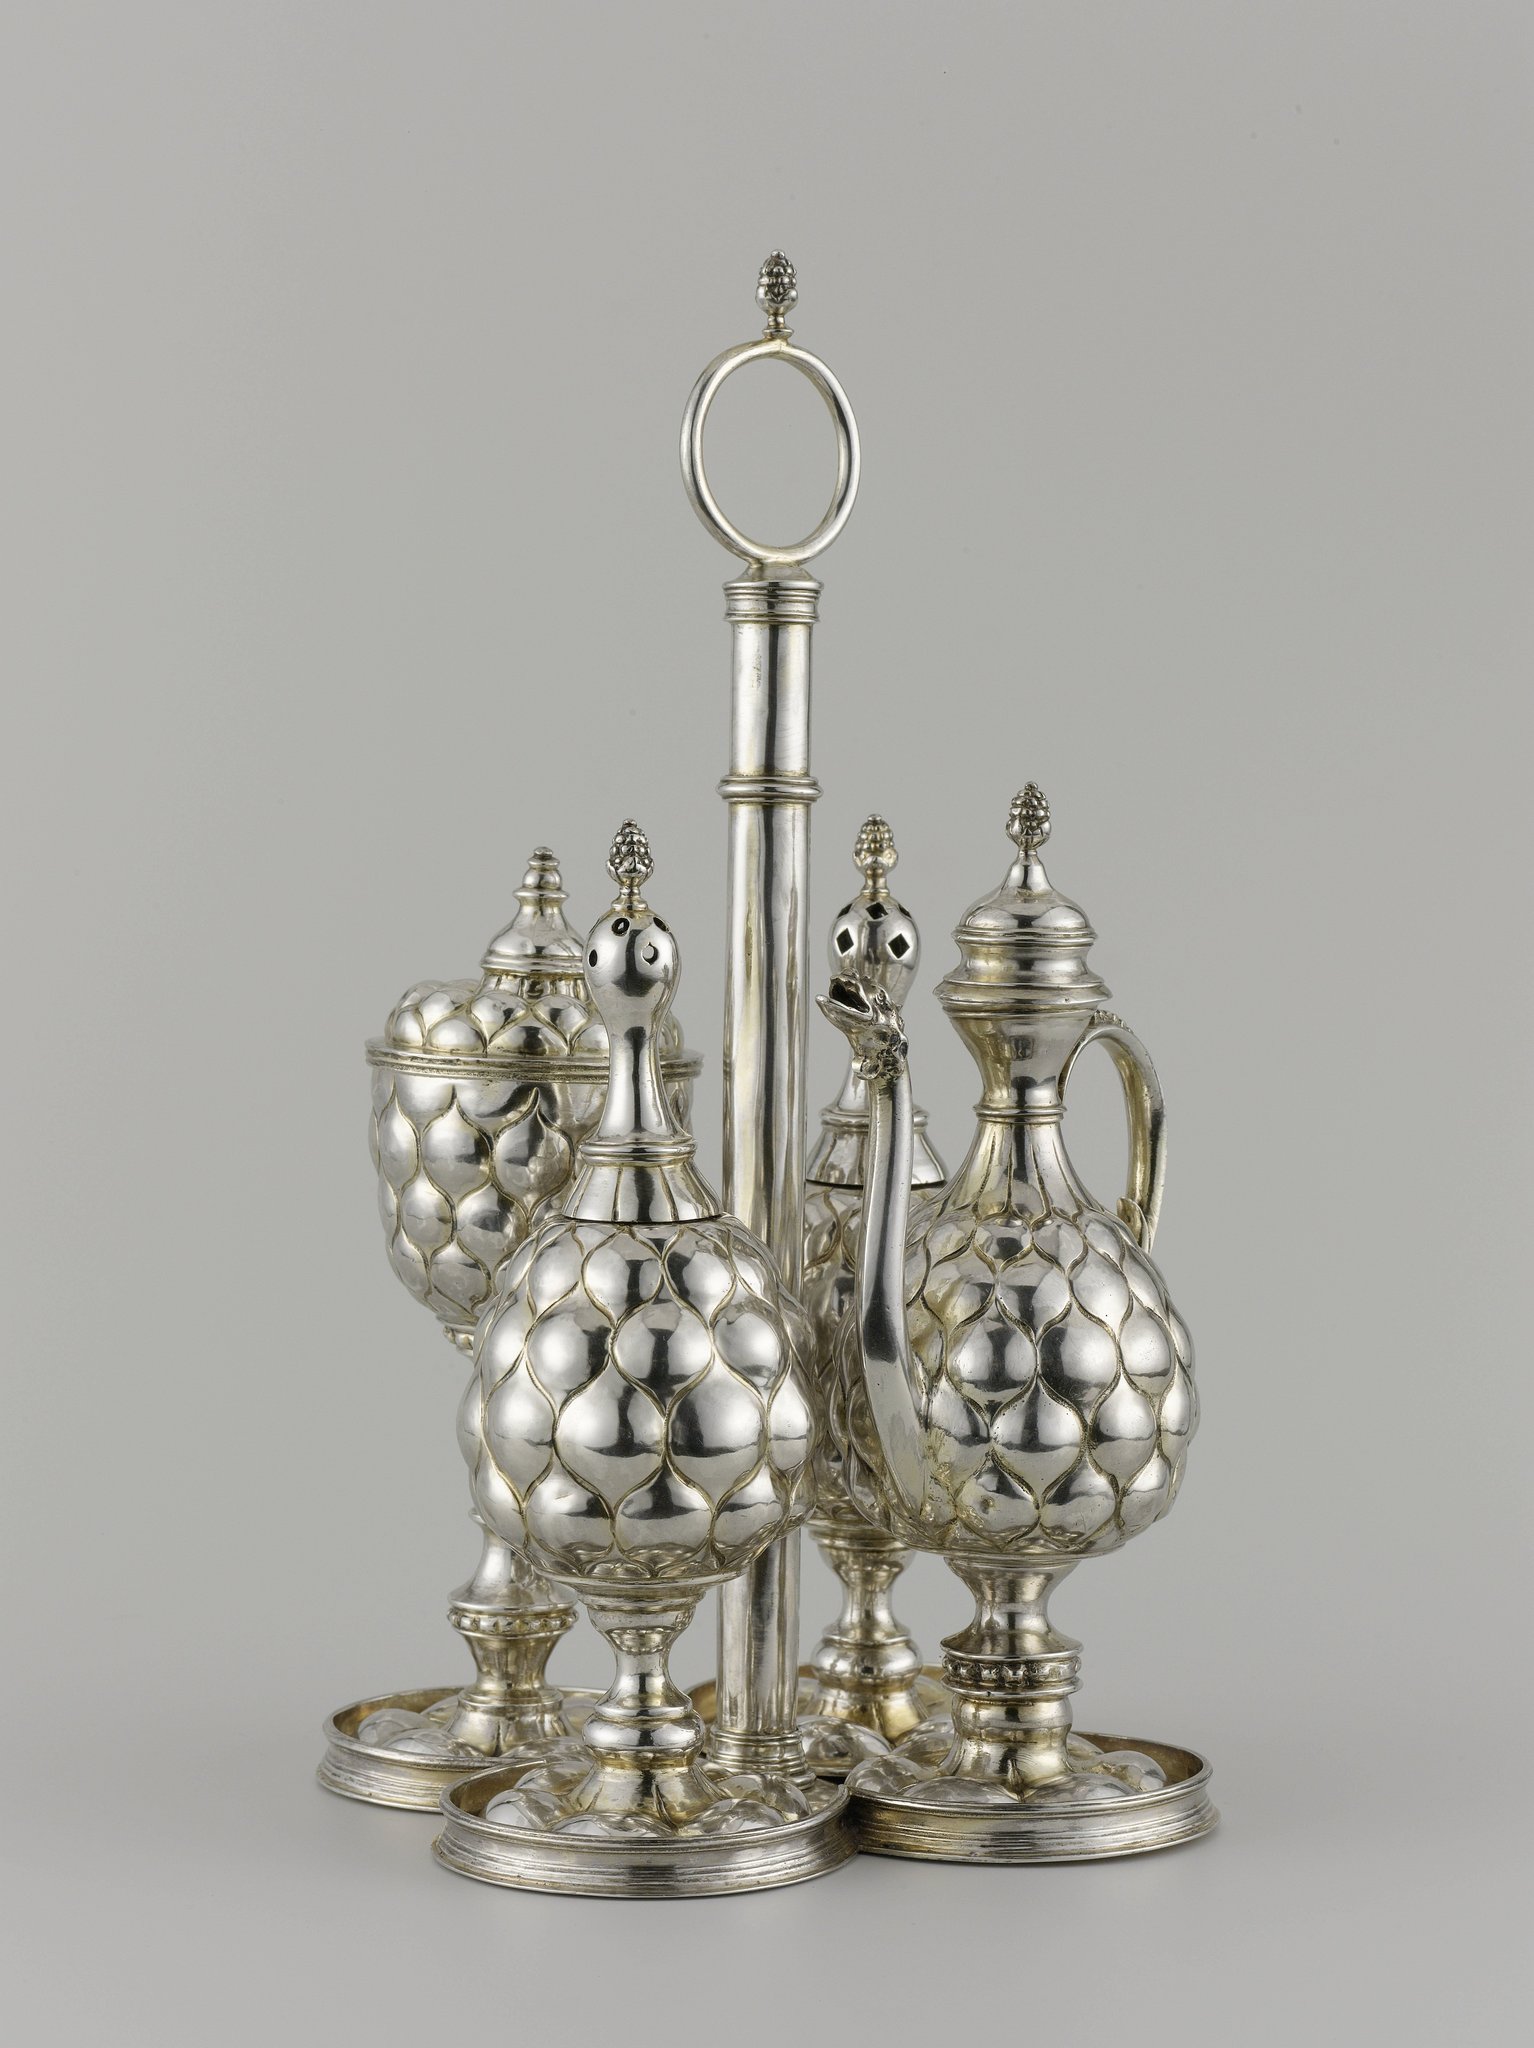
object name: salt condiment vessel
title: Zoutvat, behorende bij een specerijenservies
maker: anthonie grill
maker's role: silversmith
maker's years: 1607-1675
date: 1642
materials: silver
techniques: casting, gilding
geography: amsterdam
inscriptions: maker's mark: ‘ooievaar tussen AG in ovaal’, town mark: ‘Amsterdam’, date letter: ‘L’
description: Zoutvat , behorend bij een specerijenservies. Het zoutvat rust op een zeslobbige voet waarop zich een stapeling bevindt van respectievelijk een knerrenrand tussen twee zich spiegelende vaasvormen, een baluster, een vaasvorm en een knerrenrand. Hierboven verheft zich het half ei-vormige lichaam dat versierd is met druppelvormige uitstulpingen. Deze motieven sieren ook het afneembare deksel. Het vrij platte buitenste gedeelte daarvan zakt naar het midden toe een weinig in om zich vervolgens te verheffen in een meervoudig geprofileerde knop. Het zoutvat heeft een vaste binnenbak waarvan de vergulding nog in goede staat verkeerd.